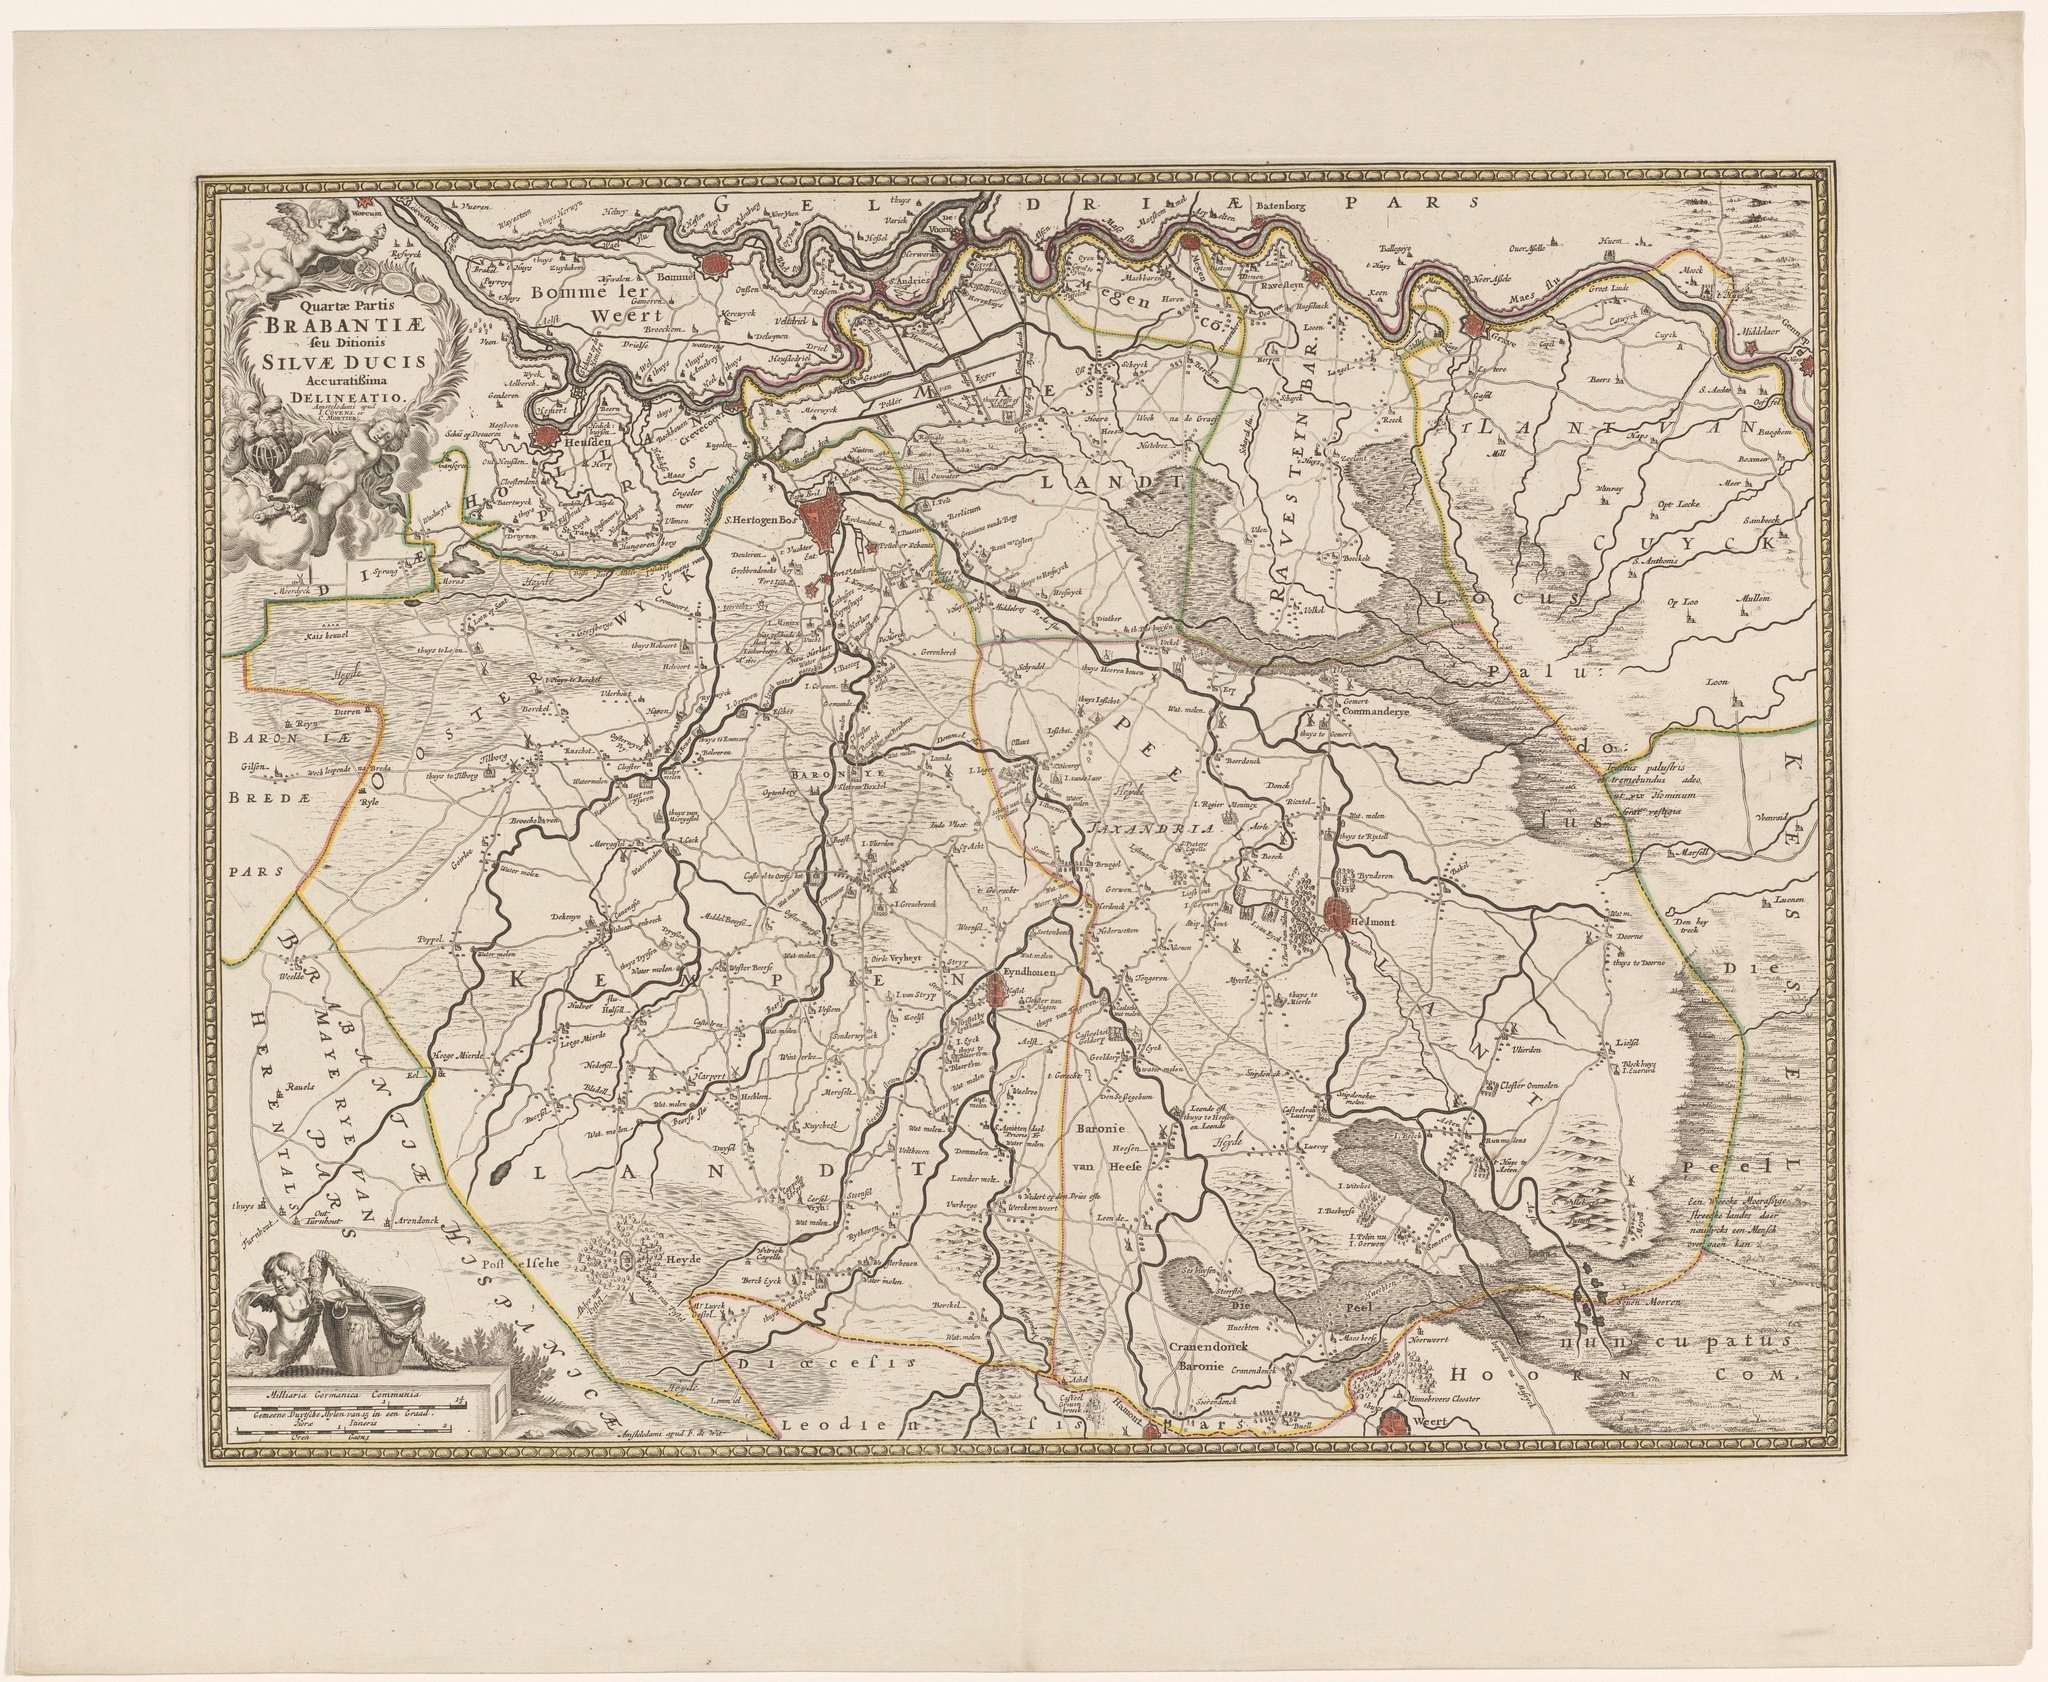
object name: print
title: Quartae partis Brabantiae seu ditionis Silvae Ducis accuratissima delineatio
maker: Anonymous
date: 1633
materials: paper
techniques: engraving, etching, hand coloring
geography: amsterdam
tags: maps of separate countries or regions, den bosch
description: Kaart van de Meierij van 's-Hertogenbosch. Linksboven de titelcartouche. Linksonder twee schaalstokken: Gemeene Duytsche Mylen van 15 in een Graad / 2 Uren Gaens.